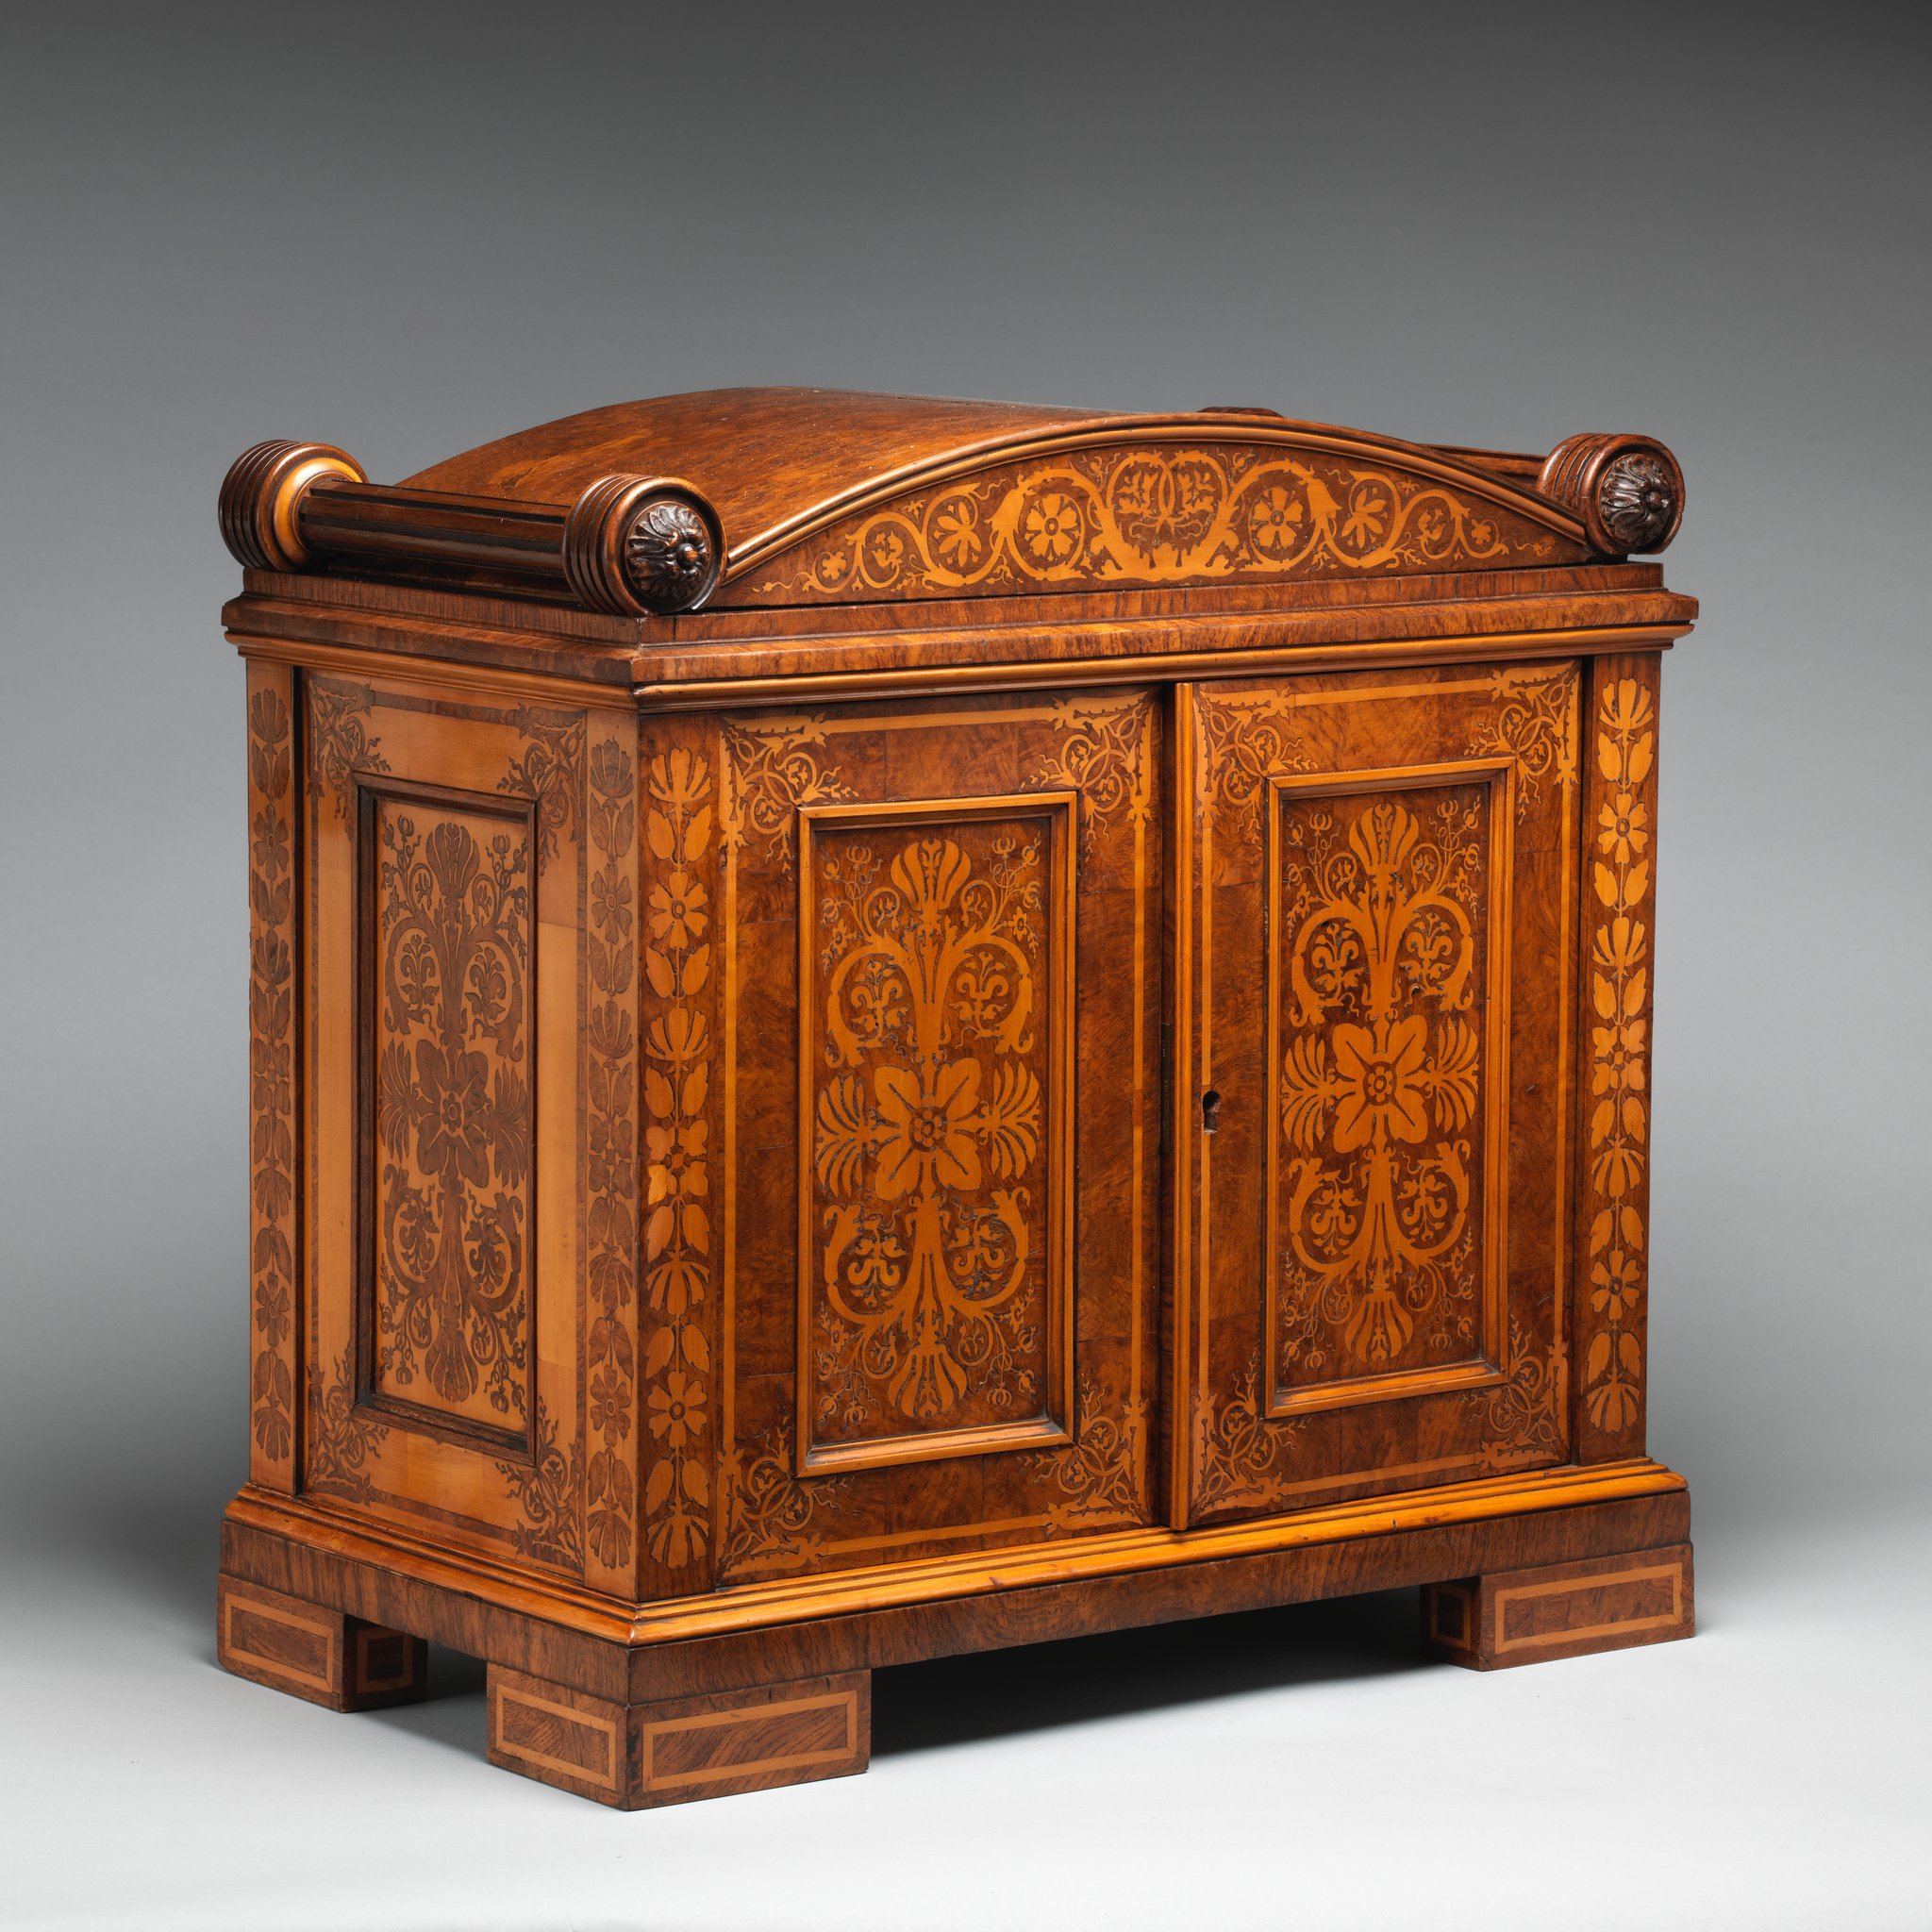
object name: medal cabinet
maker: george bullock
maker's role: maker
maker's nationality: british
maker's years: 1775-1818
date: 1814-1818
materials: wood, ivory, silk, velvet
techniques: veneering